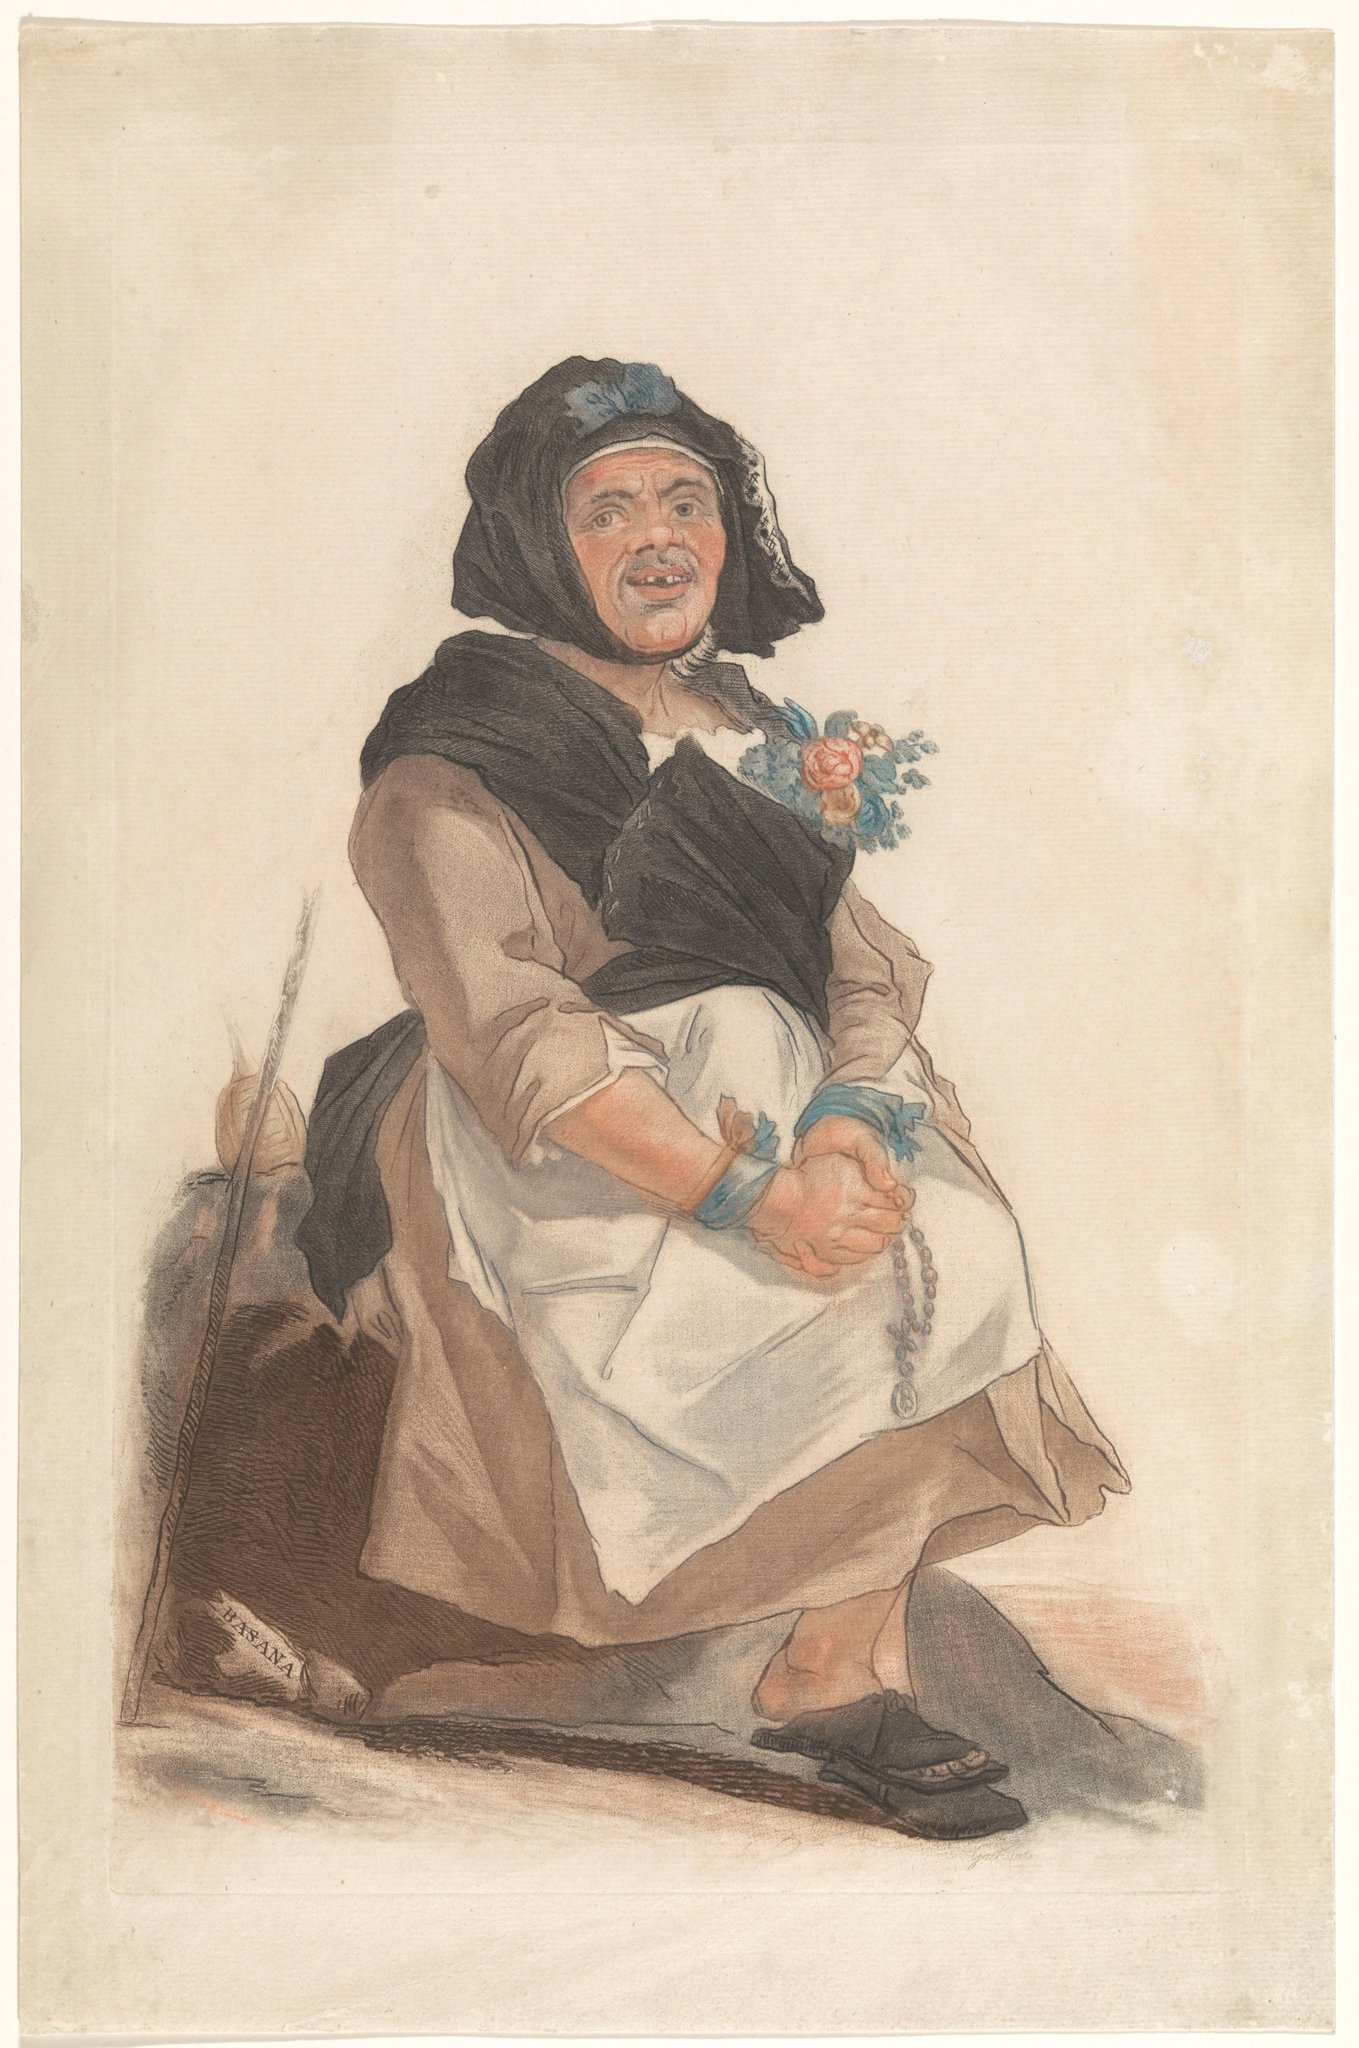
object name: print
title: Ritratti di persone facette che servono a divertire il pubblico fiorentino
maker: carlo lasinio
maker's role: painter, print maker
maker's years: 1759-1838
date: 1790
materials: paper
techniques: lithography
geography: florence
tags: man dressed as woman, travesty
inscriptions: watermark: ‘leeuw in ovaal’, collector's mark: Lugt 2228, collector's mark: Lugt 2760